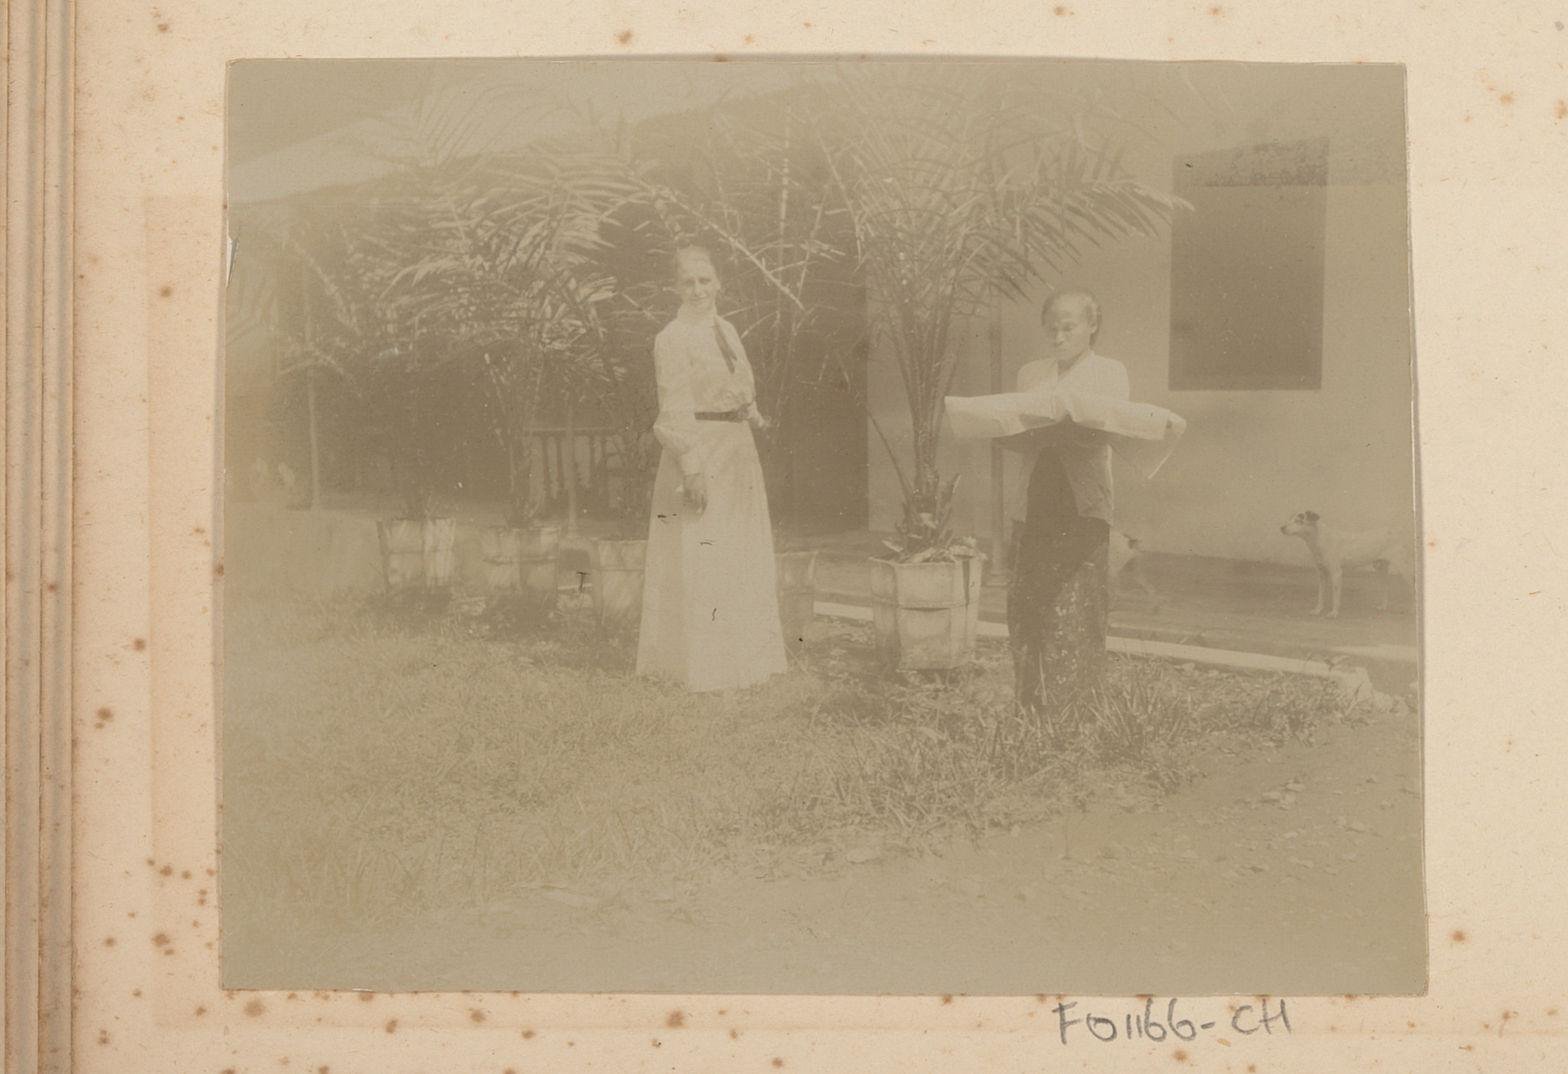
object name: album leaf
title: Nederlands-Indië, Hollandse en inlandse vrouw bij voorgalerij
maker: Anonymous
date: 1880-1910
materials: photographic support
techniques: gelatin silver print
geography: dutch east indies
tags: europeans, asiatic races and peoples, adult woman, historical persons, dutch east indies, the